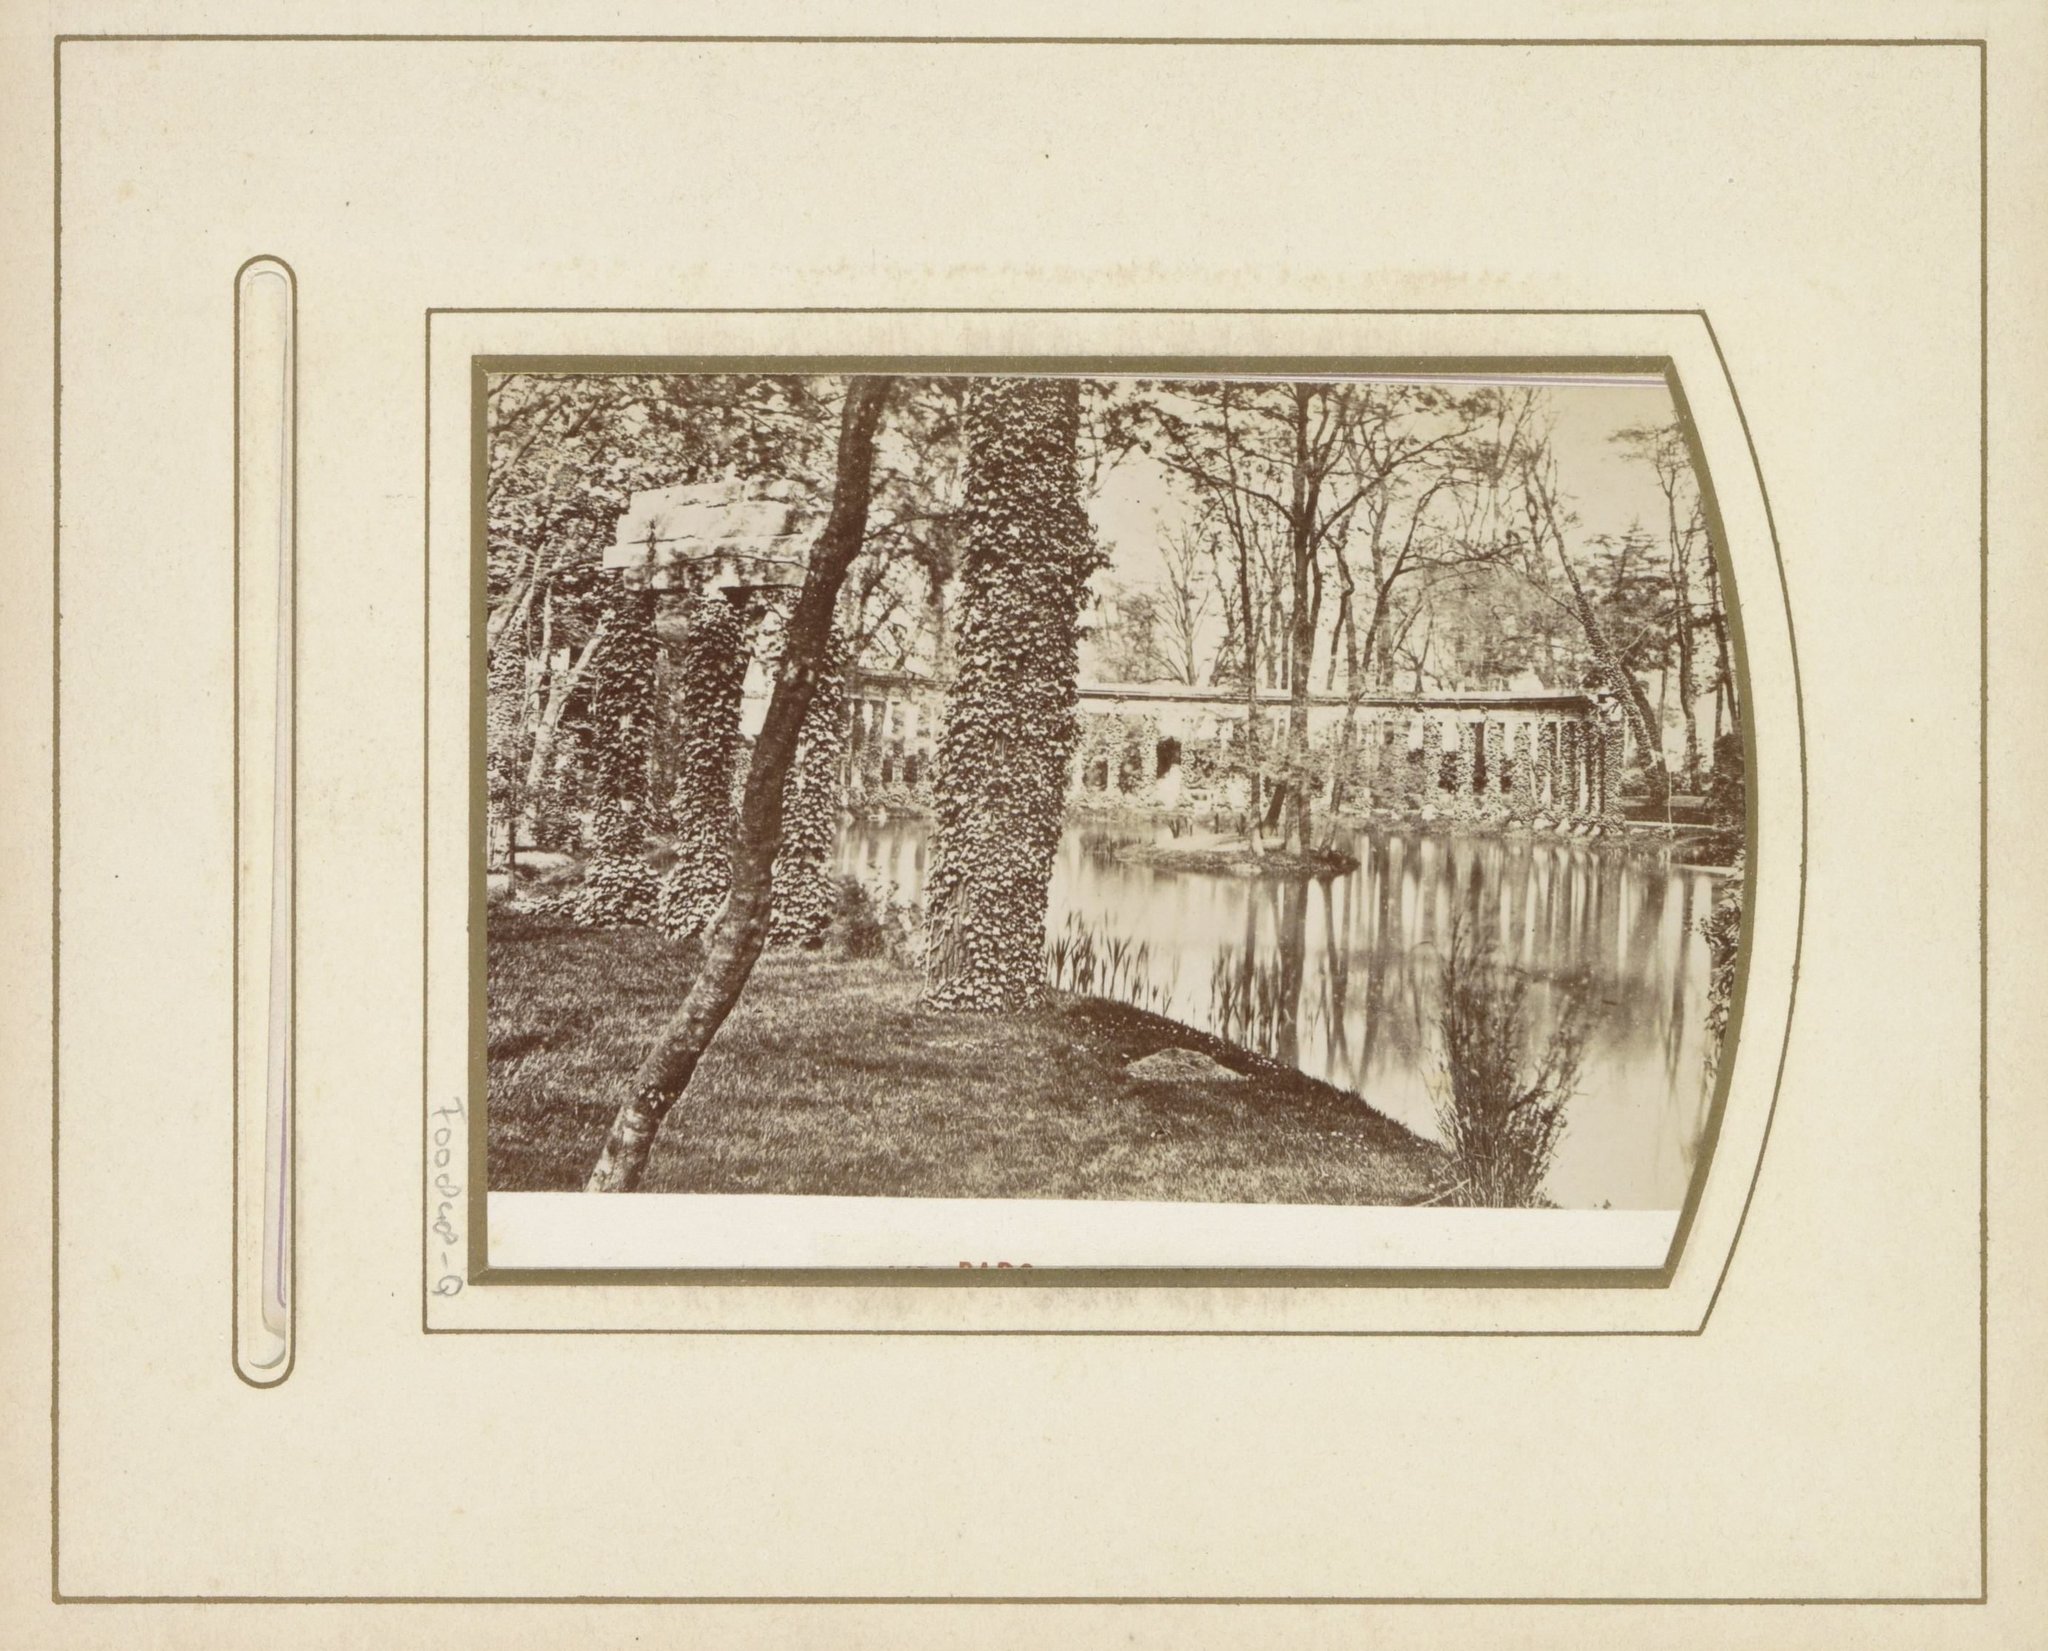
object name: photograph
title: Gezicht op een vijver, gebouwen en bomen in Parc Monceau in Parijs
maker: ernest ladrey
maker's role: fotograaf, illustrator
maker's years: 1830-1889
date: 1870-1900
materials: cardboard, paper, photographic support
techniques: albumen print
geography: paris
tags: public gardens, park (+ city(-scape) with figures, staffage), paris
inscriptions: number: ‘446.’, address: ‘Passage des Princes PARIS.’, inscription: ‘Maison Martinet Albert Hautecoeur 12, Bd des Capucines’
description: Onderdeel van Fotoalbum met kabinetfoto's van bezienswaardigheden in Parijs en Versailles.